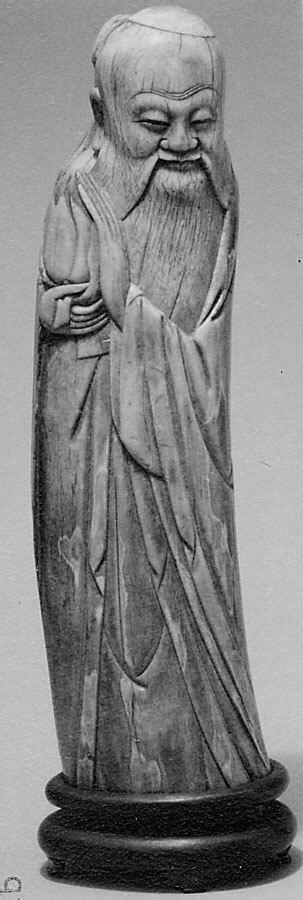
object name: statuette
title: Shoulao, God of Longevity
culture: chinese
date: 1368-1644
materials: ivory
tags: men